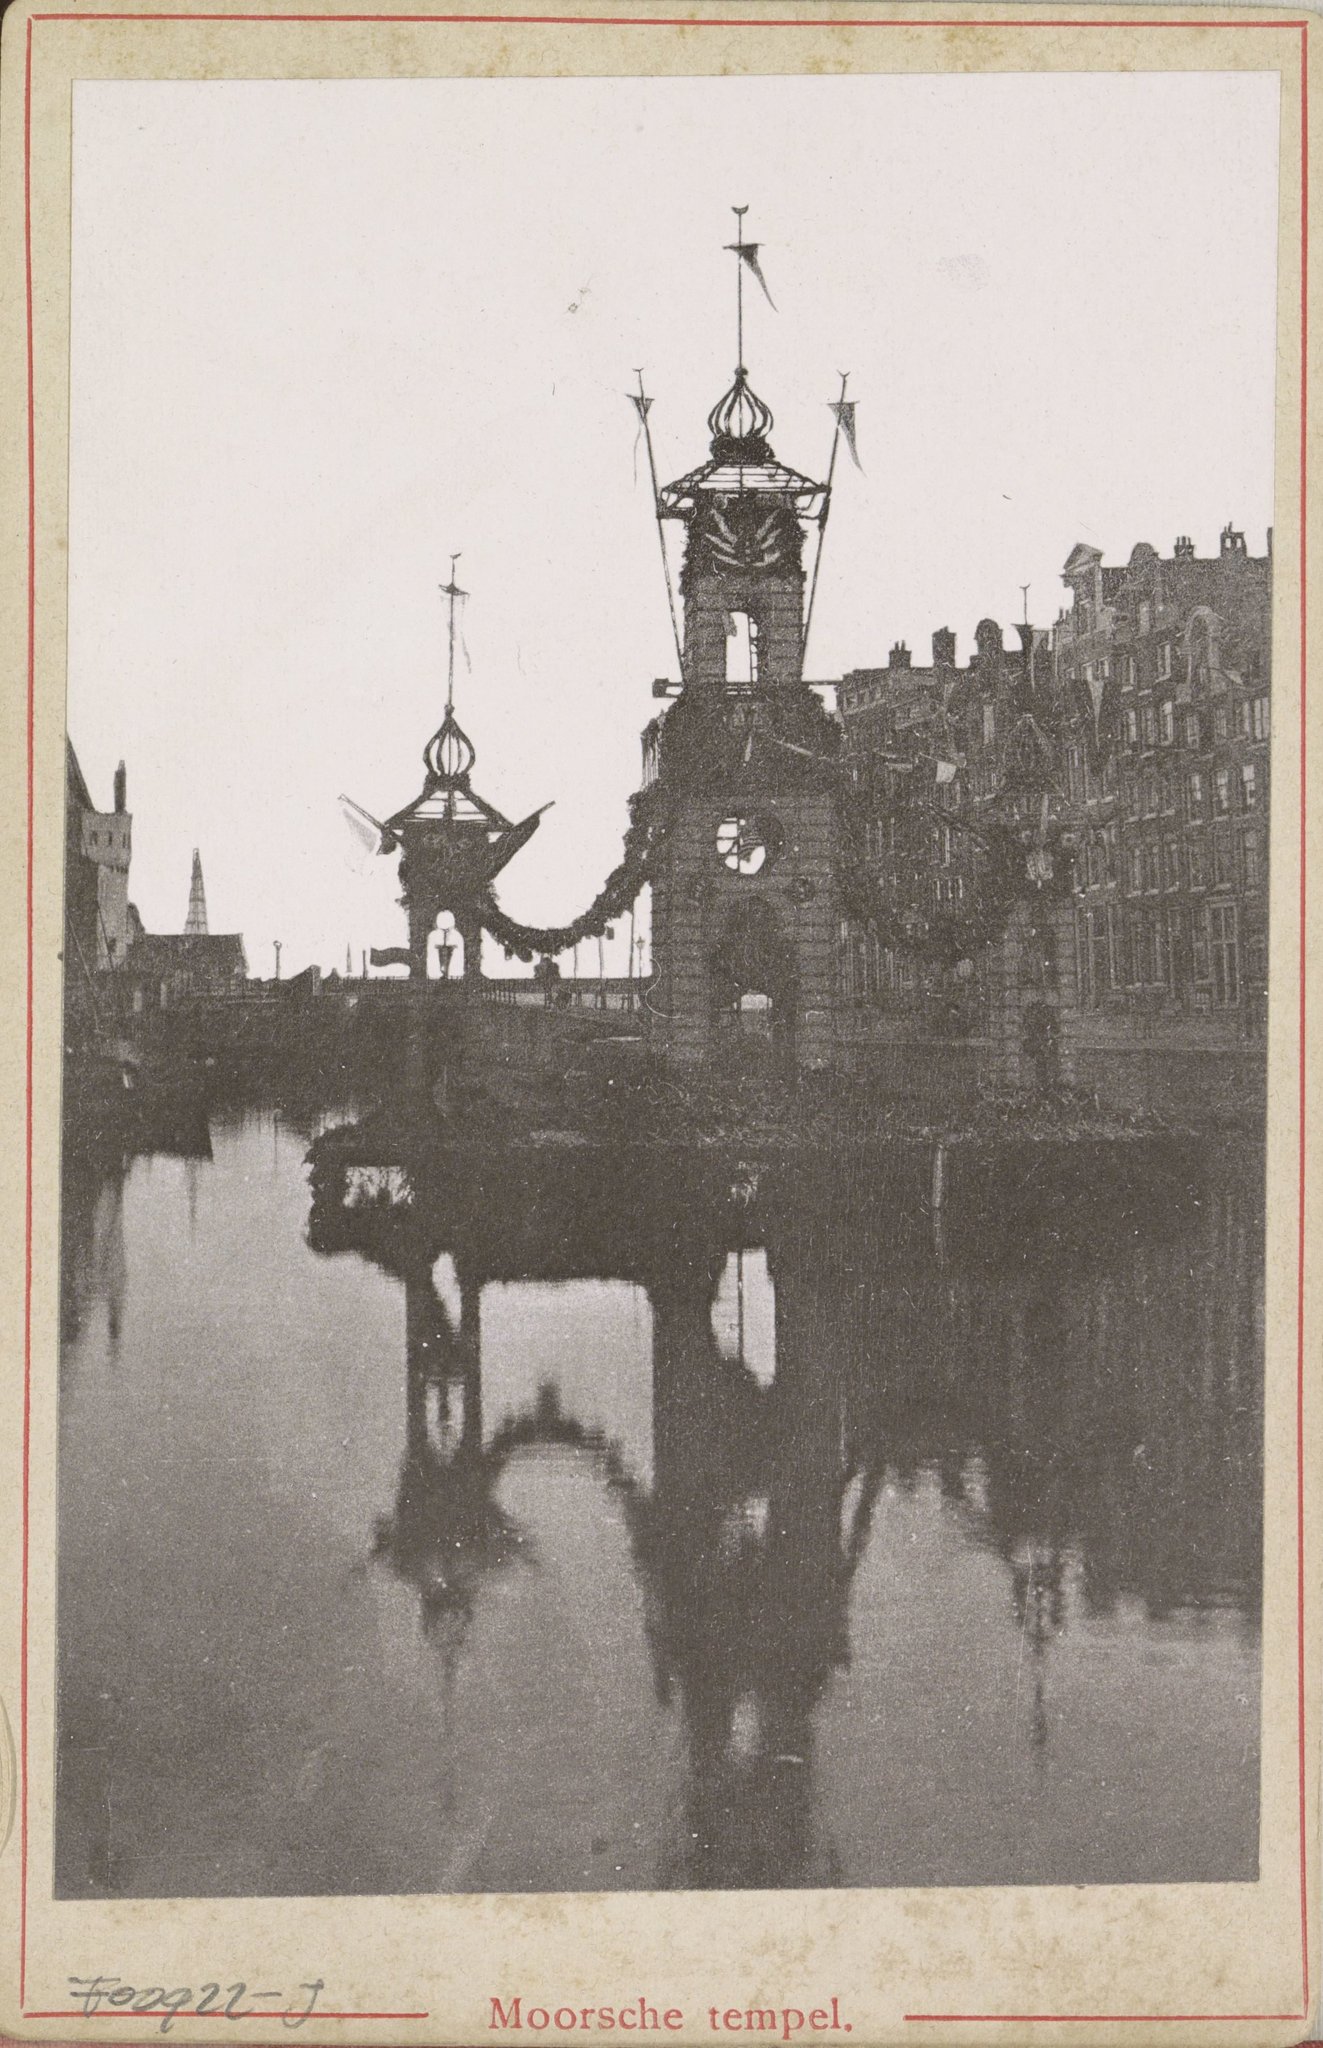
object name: cabinet photograph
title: Moorsche Tempel.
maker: Anonymous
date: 1804-1887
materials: cardboard, paper, ink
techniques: photograph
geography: amsterdam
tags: temple, shrine ~ non-christian religions, prospect of city, town panorama, silhouette of city, amsterdam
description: Onderdeel van Fotoalbum met opnames van de Aprilfeesten in 1887 te Amsterdam.